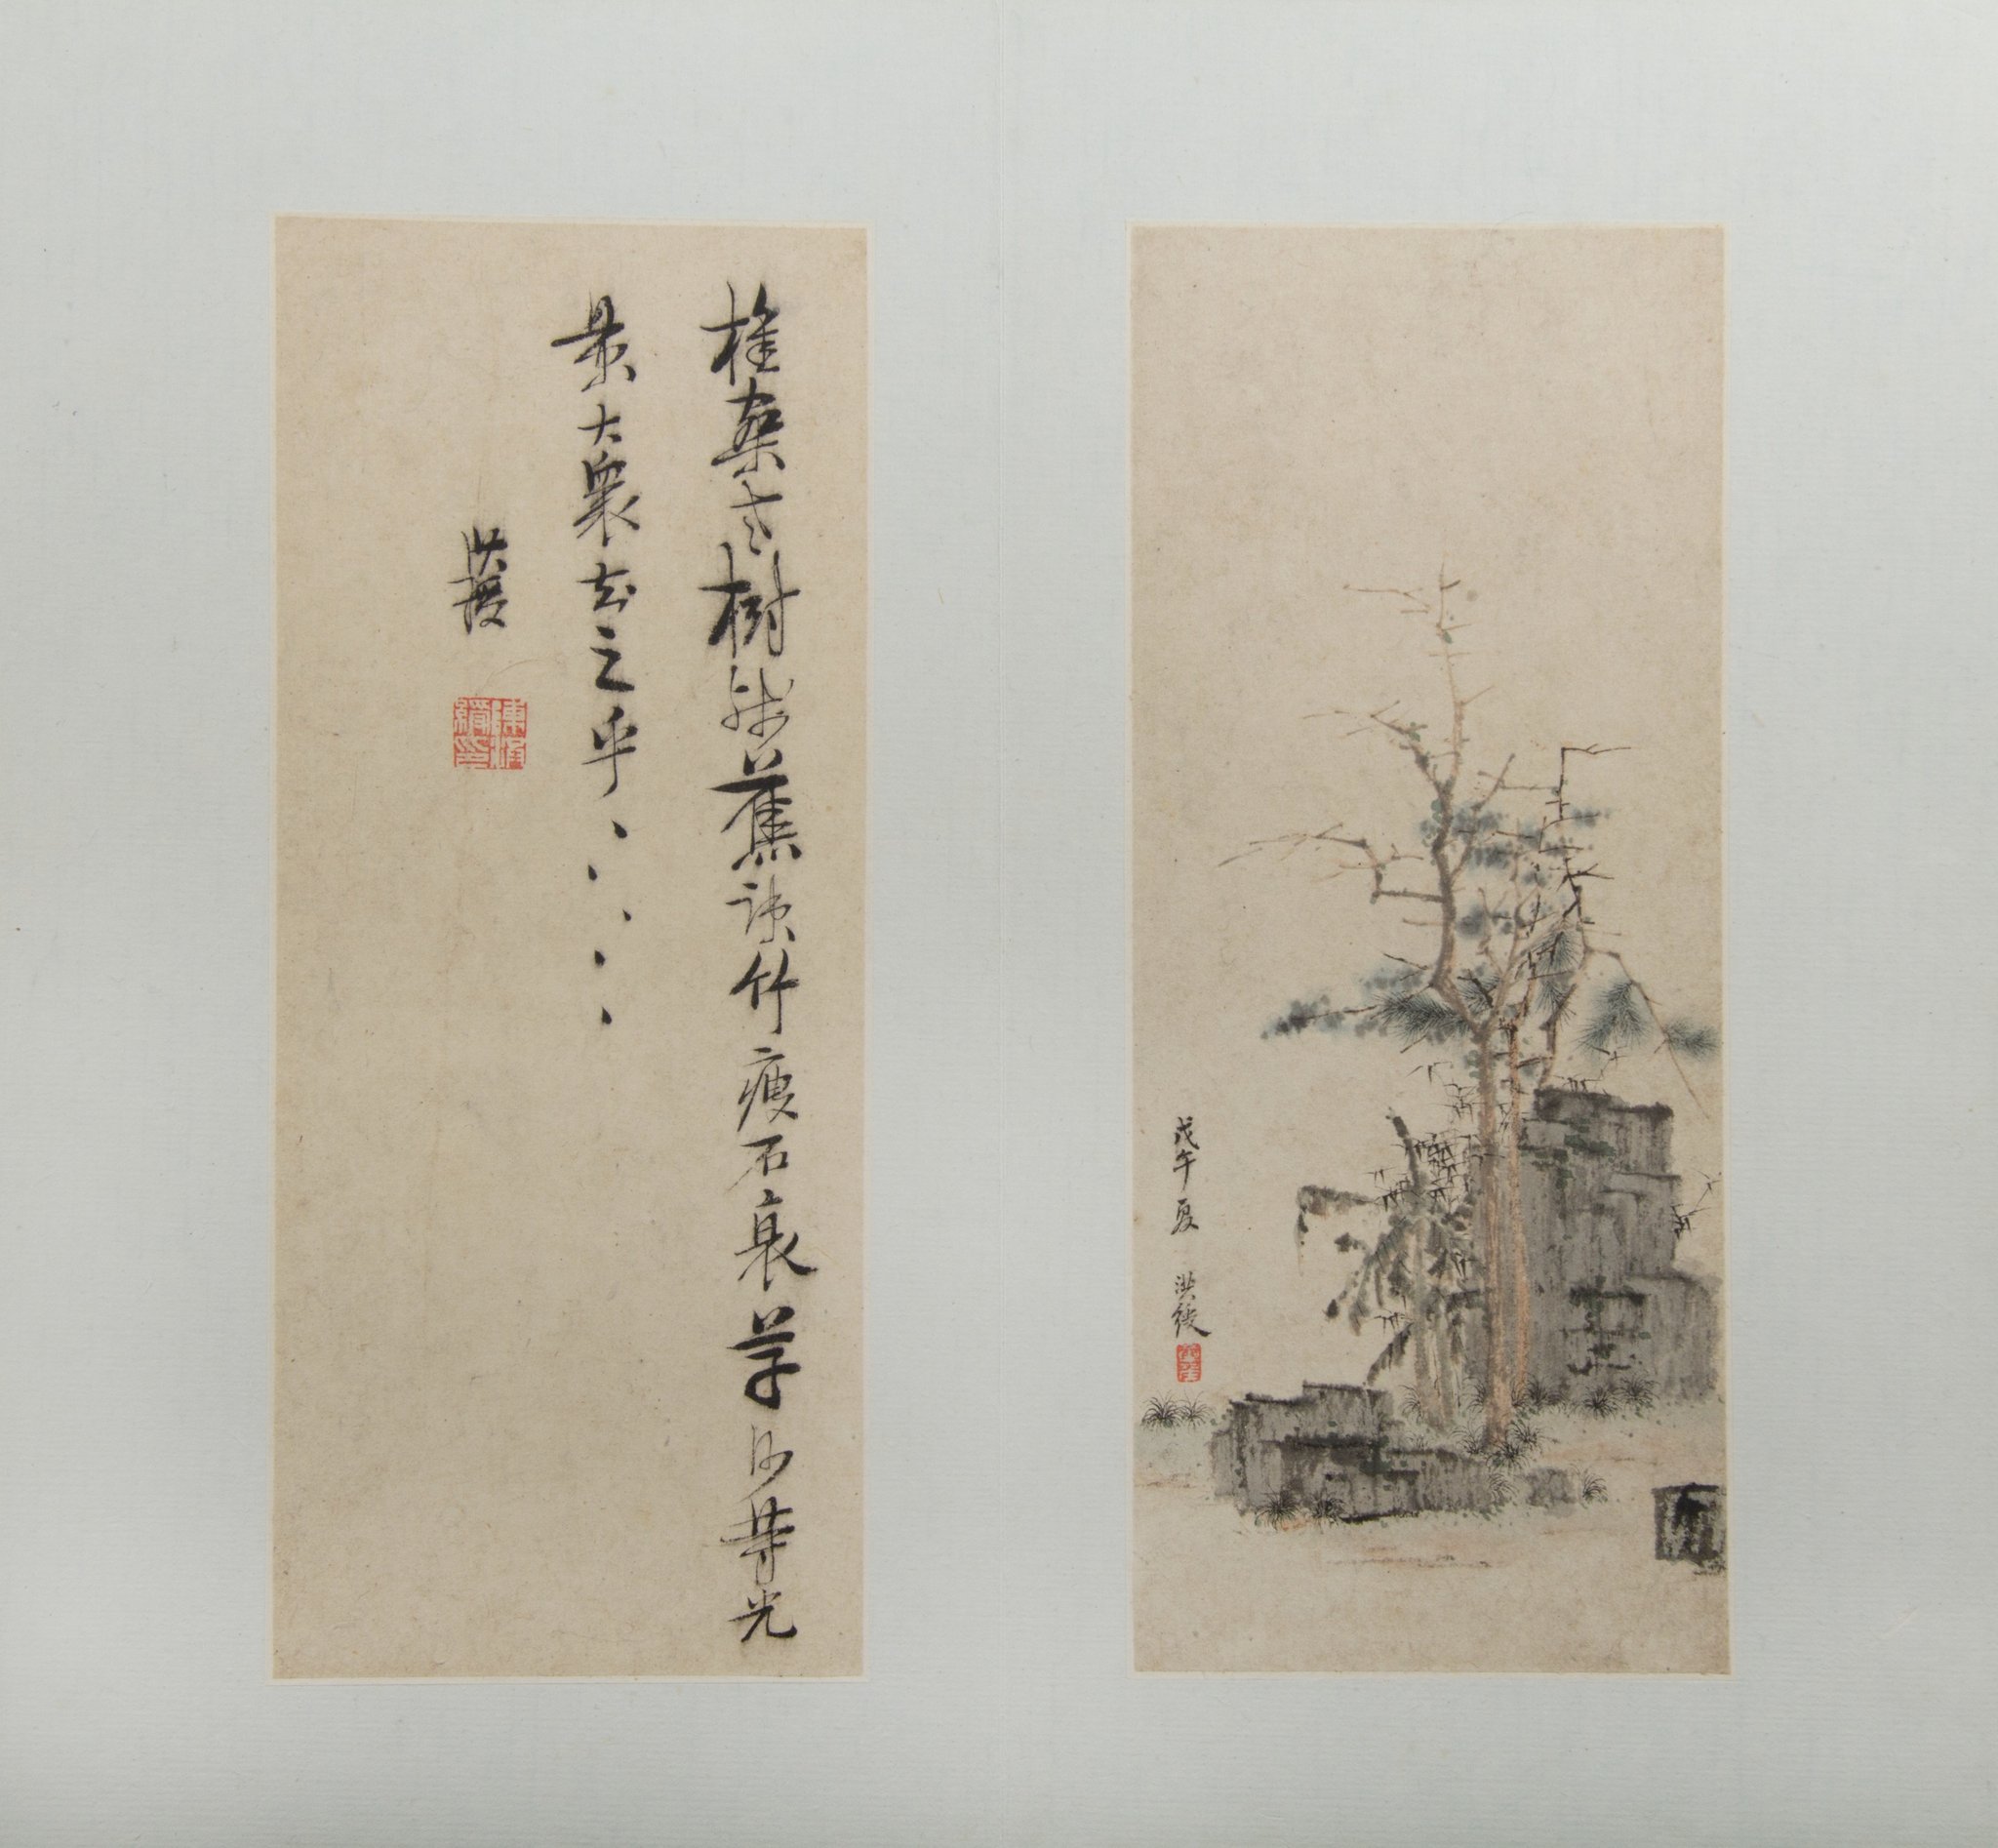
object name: album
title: Landscapes, Figures, and Flowers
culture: chinese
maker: chen hongshou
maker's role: artist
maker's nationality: chinese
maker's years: 1598-1652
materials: ink, paper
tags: landscapes